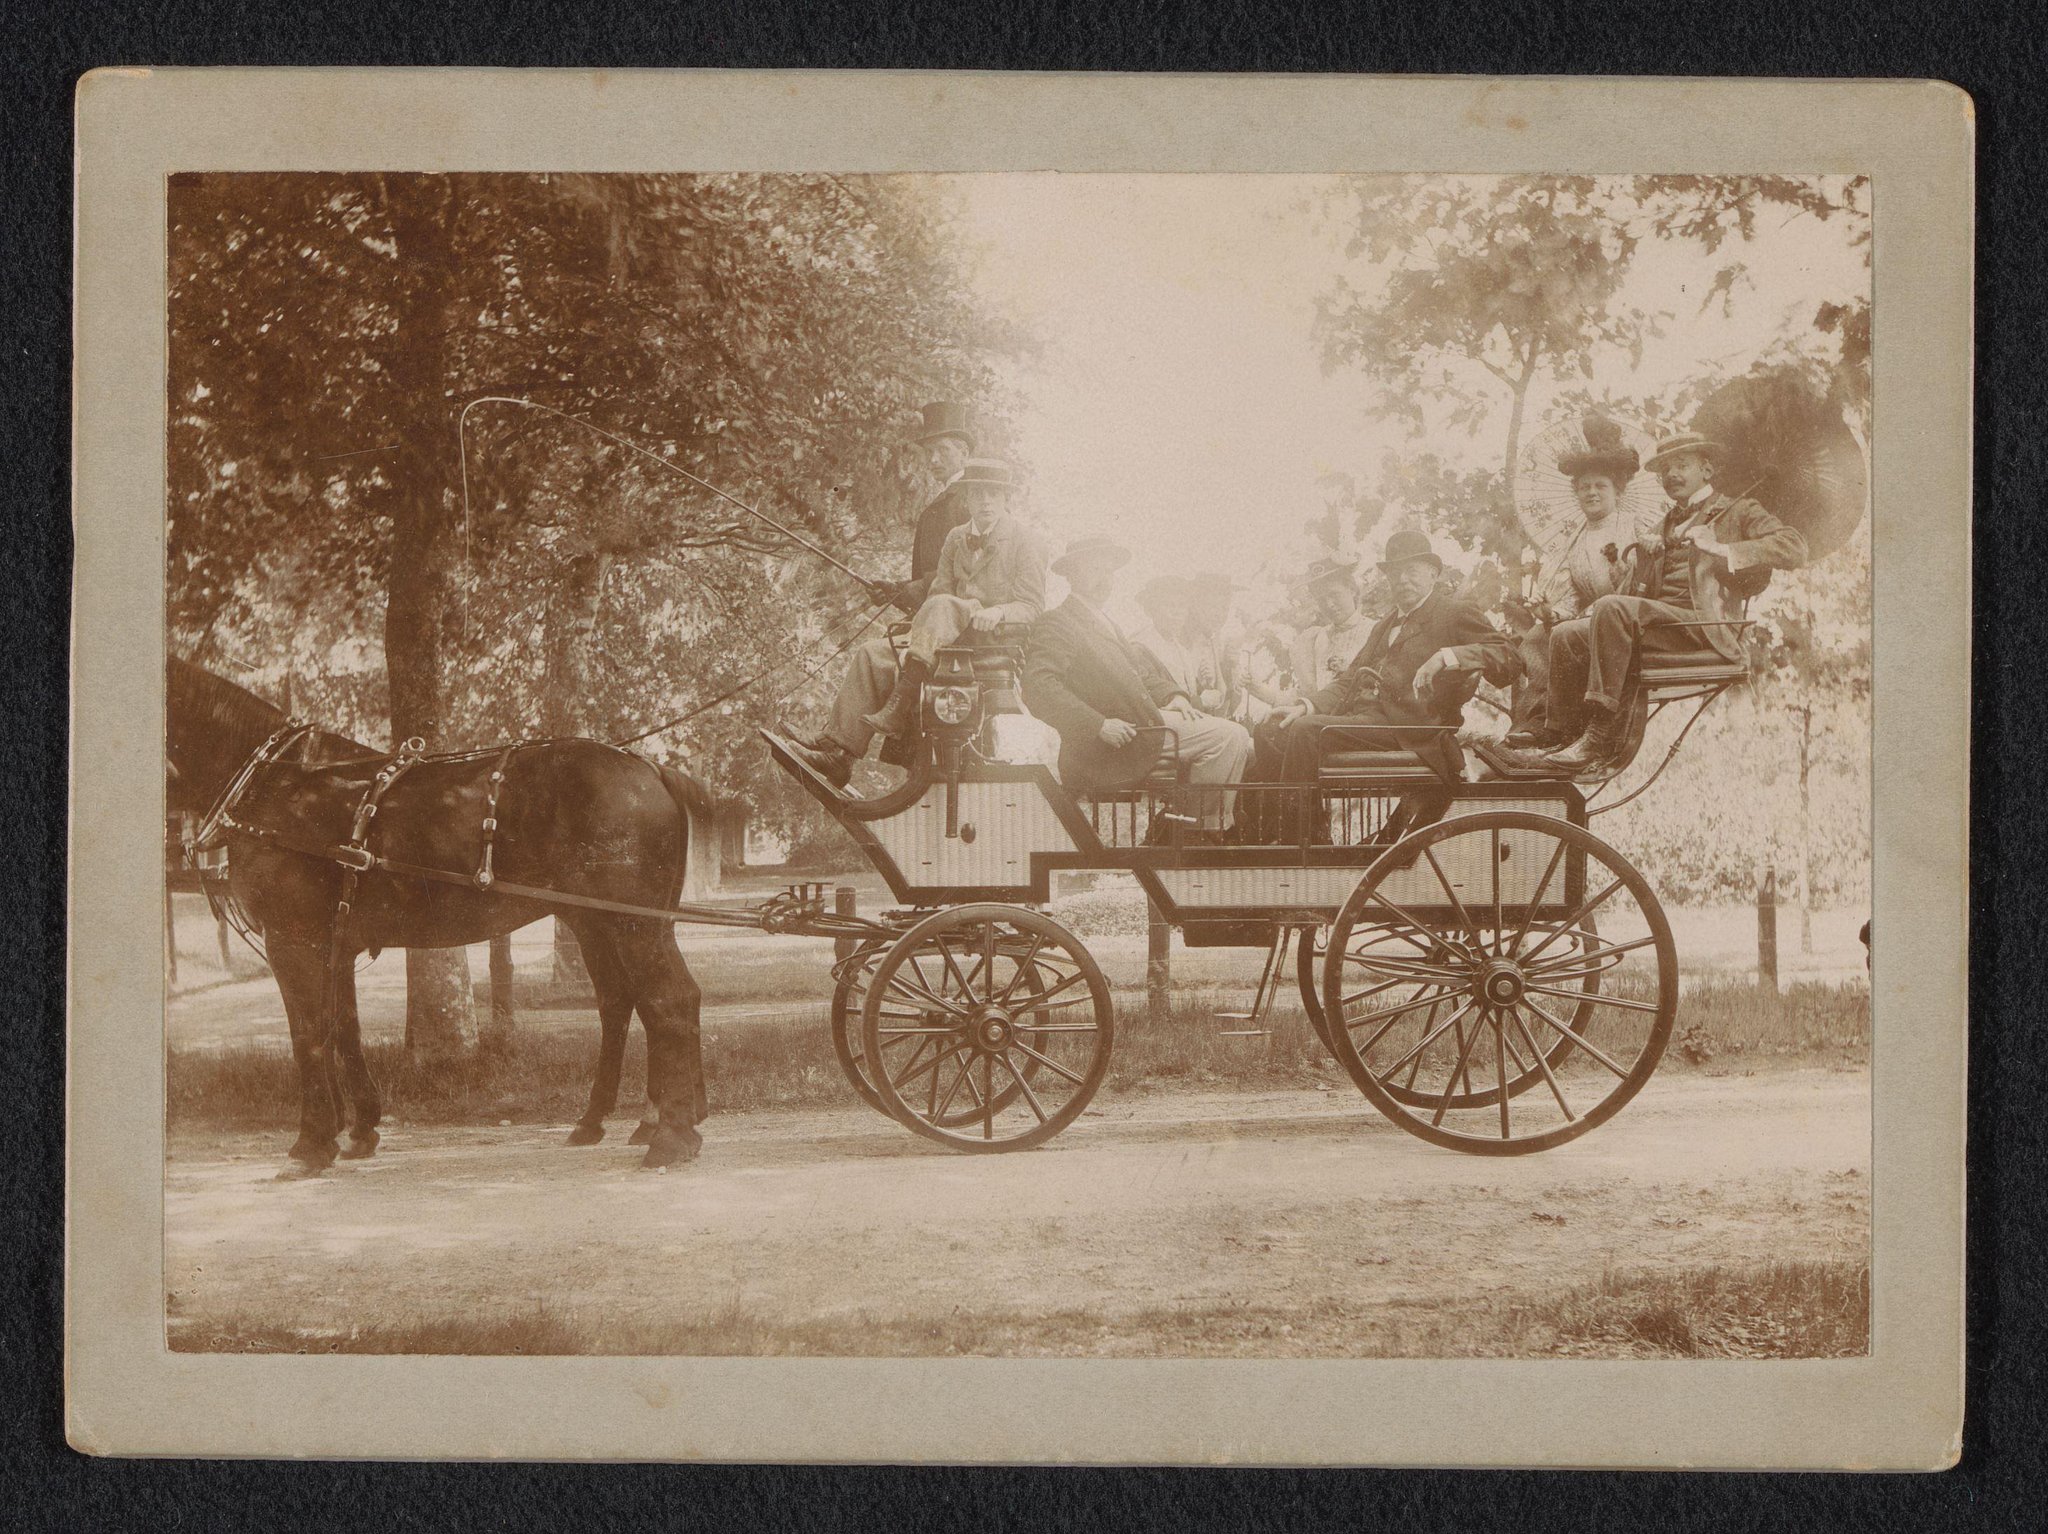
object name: photograph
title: Familie van den Berg op paard en wagen in Baarn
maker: hendrik herman van den berg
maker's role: amateurfotograaf, jurist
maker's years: 1875-1944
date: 1896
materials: cardboard, photographic support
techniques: collodion silver print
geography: baarn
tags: rotterdam, amsterdam, norbertus petrus van den berg (1831-1917), four-wheeled, animal-drawn vehicle, e.g.: cab, carriage, coach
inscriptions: inscription: ‘1896 Baarn op de bok Herman Stelling; vader; oom Wim; tante Jeanne; grootvader N.P.; tante Leo; oom Karel, moeder’